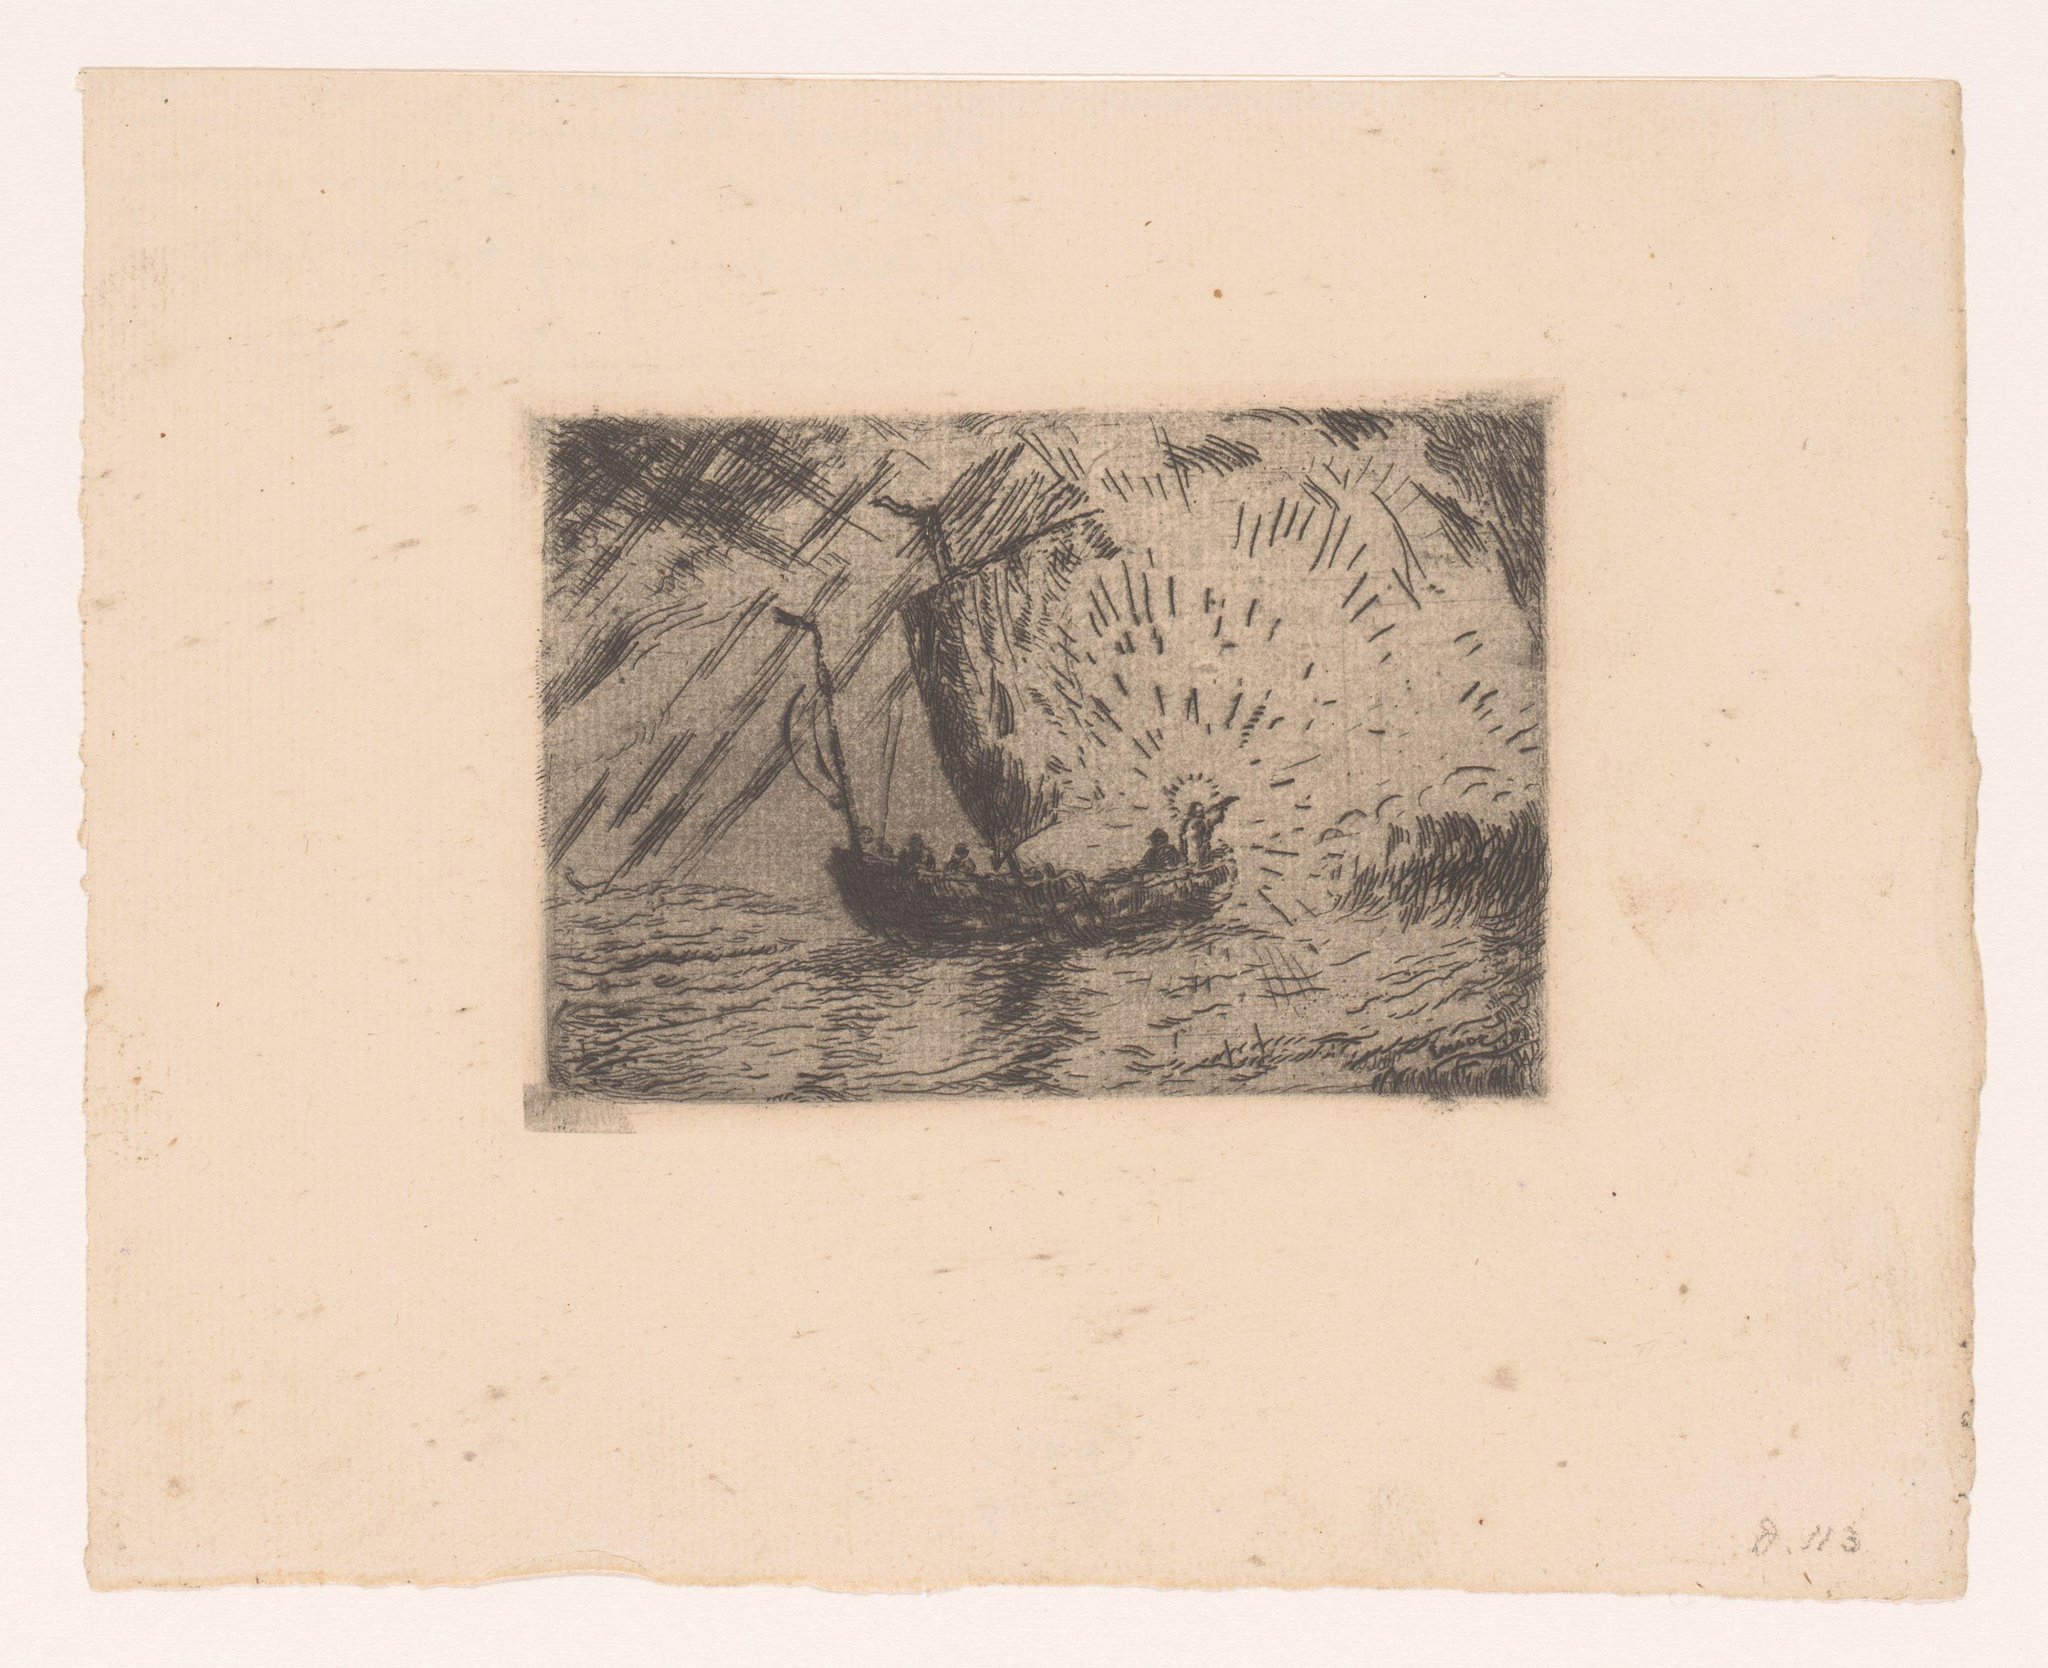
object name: print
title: Le Christ dans la barque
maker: james ensor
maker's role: print maker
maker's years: 1860-1949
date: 1898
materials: paper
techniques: etching, intaglio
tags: story of christ stilling the storm on the sea of galilee (matthew 8:23-27; mark 4:35-41; luke 8:22-25)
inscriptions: collector's mark: Lugt 2228